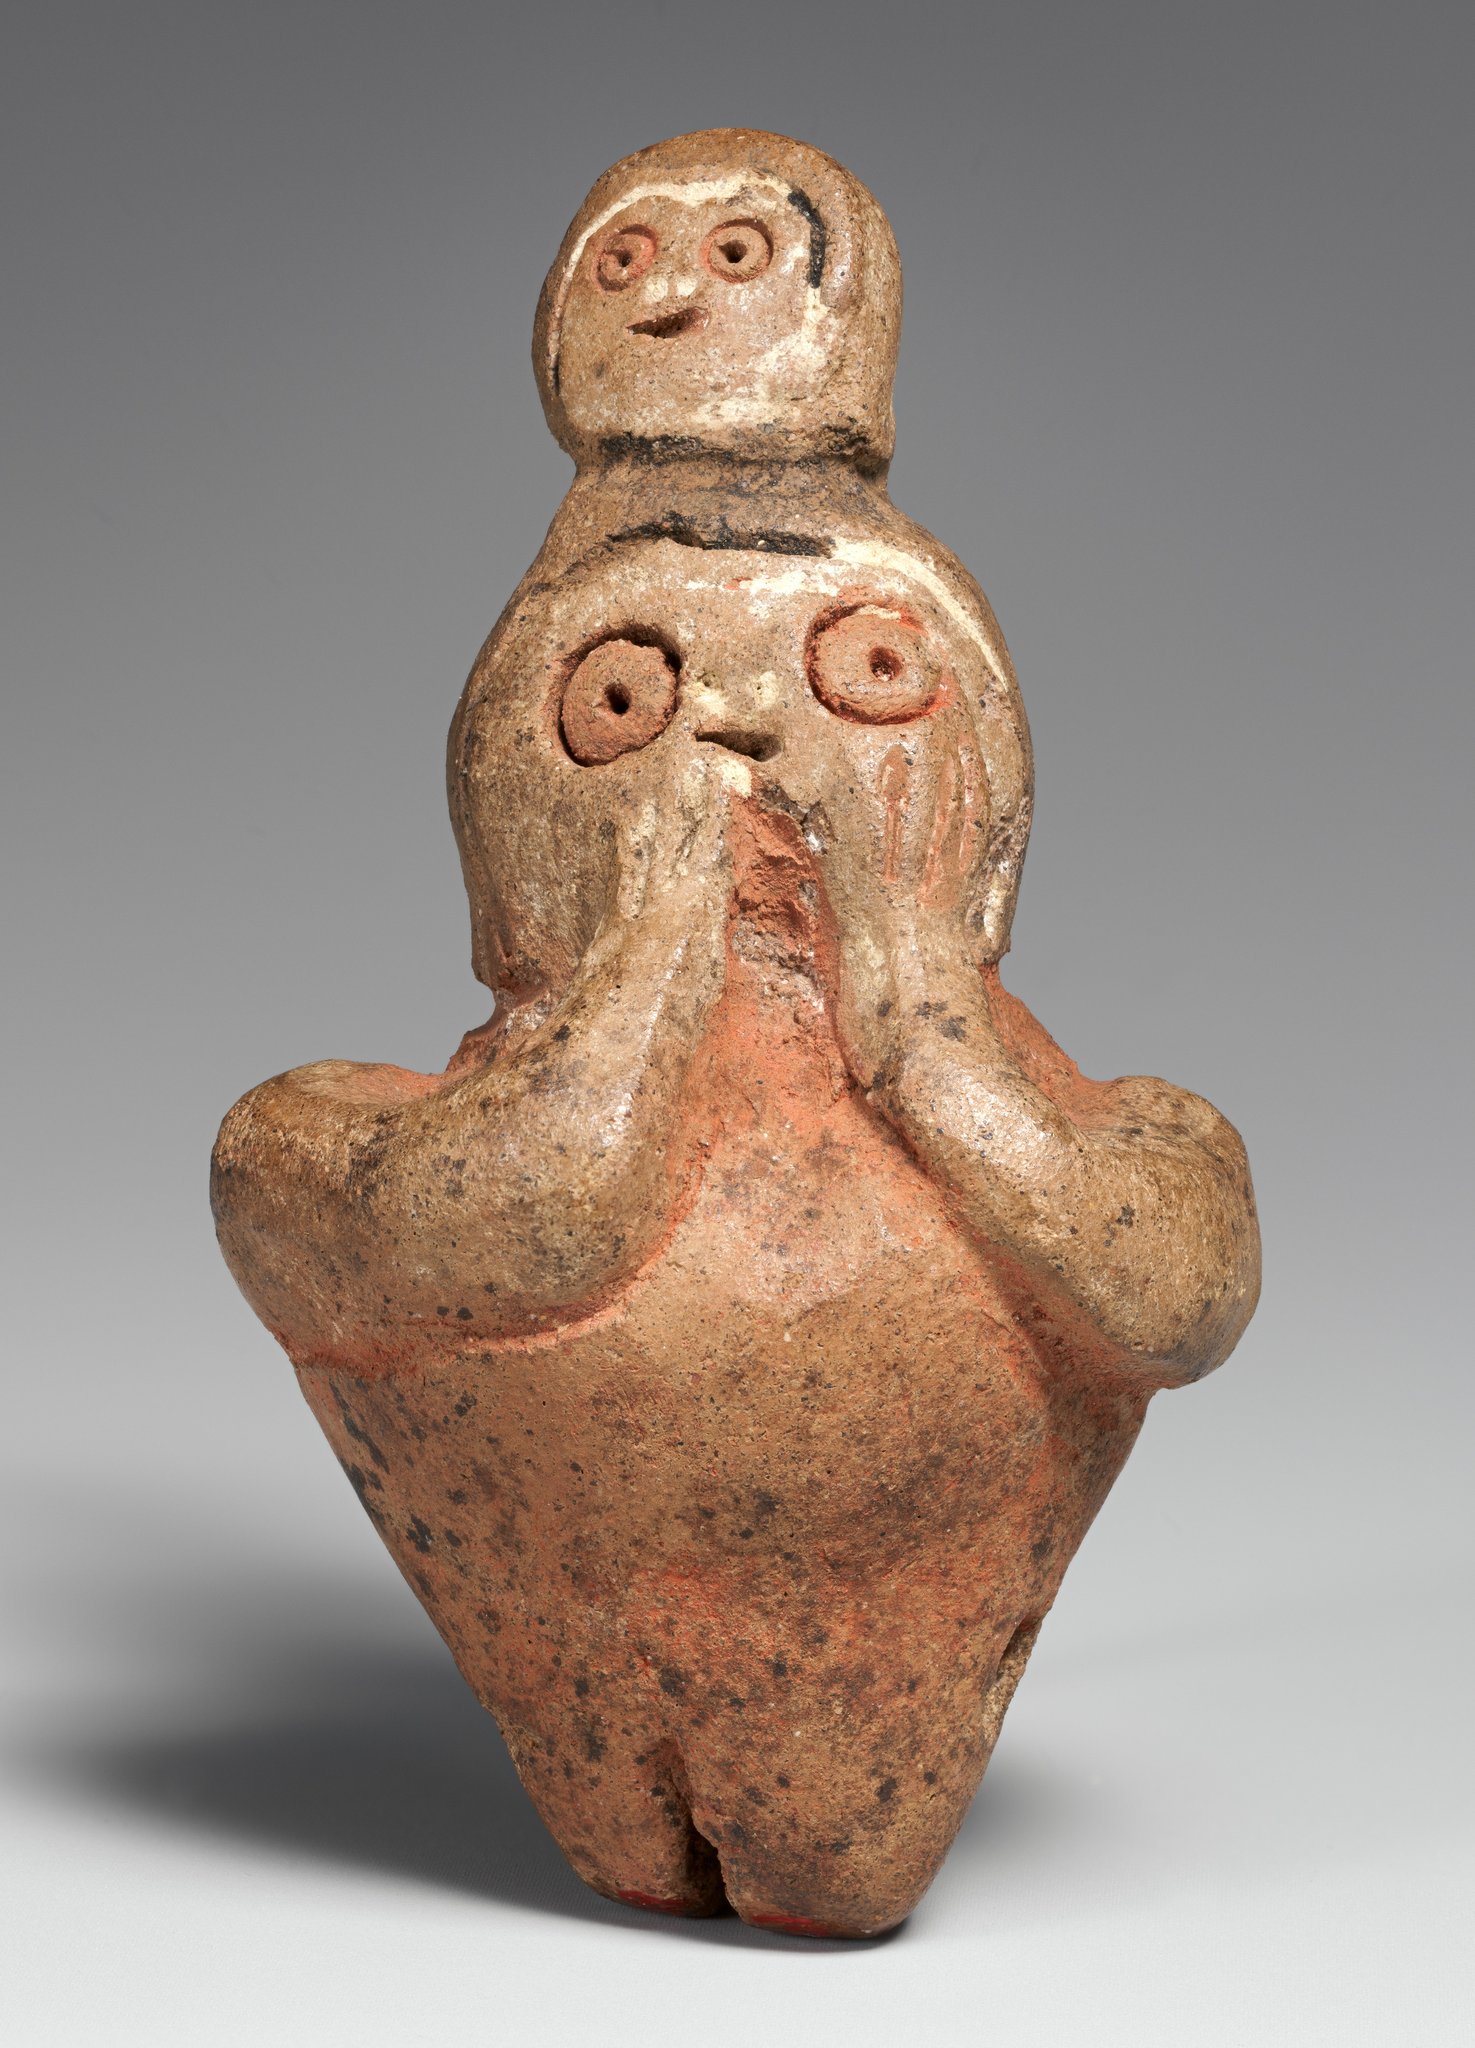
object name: whistle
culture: cupisnique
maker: cupisnique artist(s)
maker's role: artist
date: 1200-500 BCE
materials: ceramic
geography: peru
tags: heads